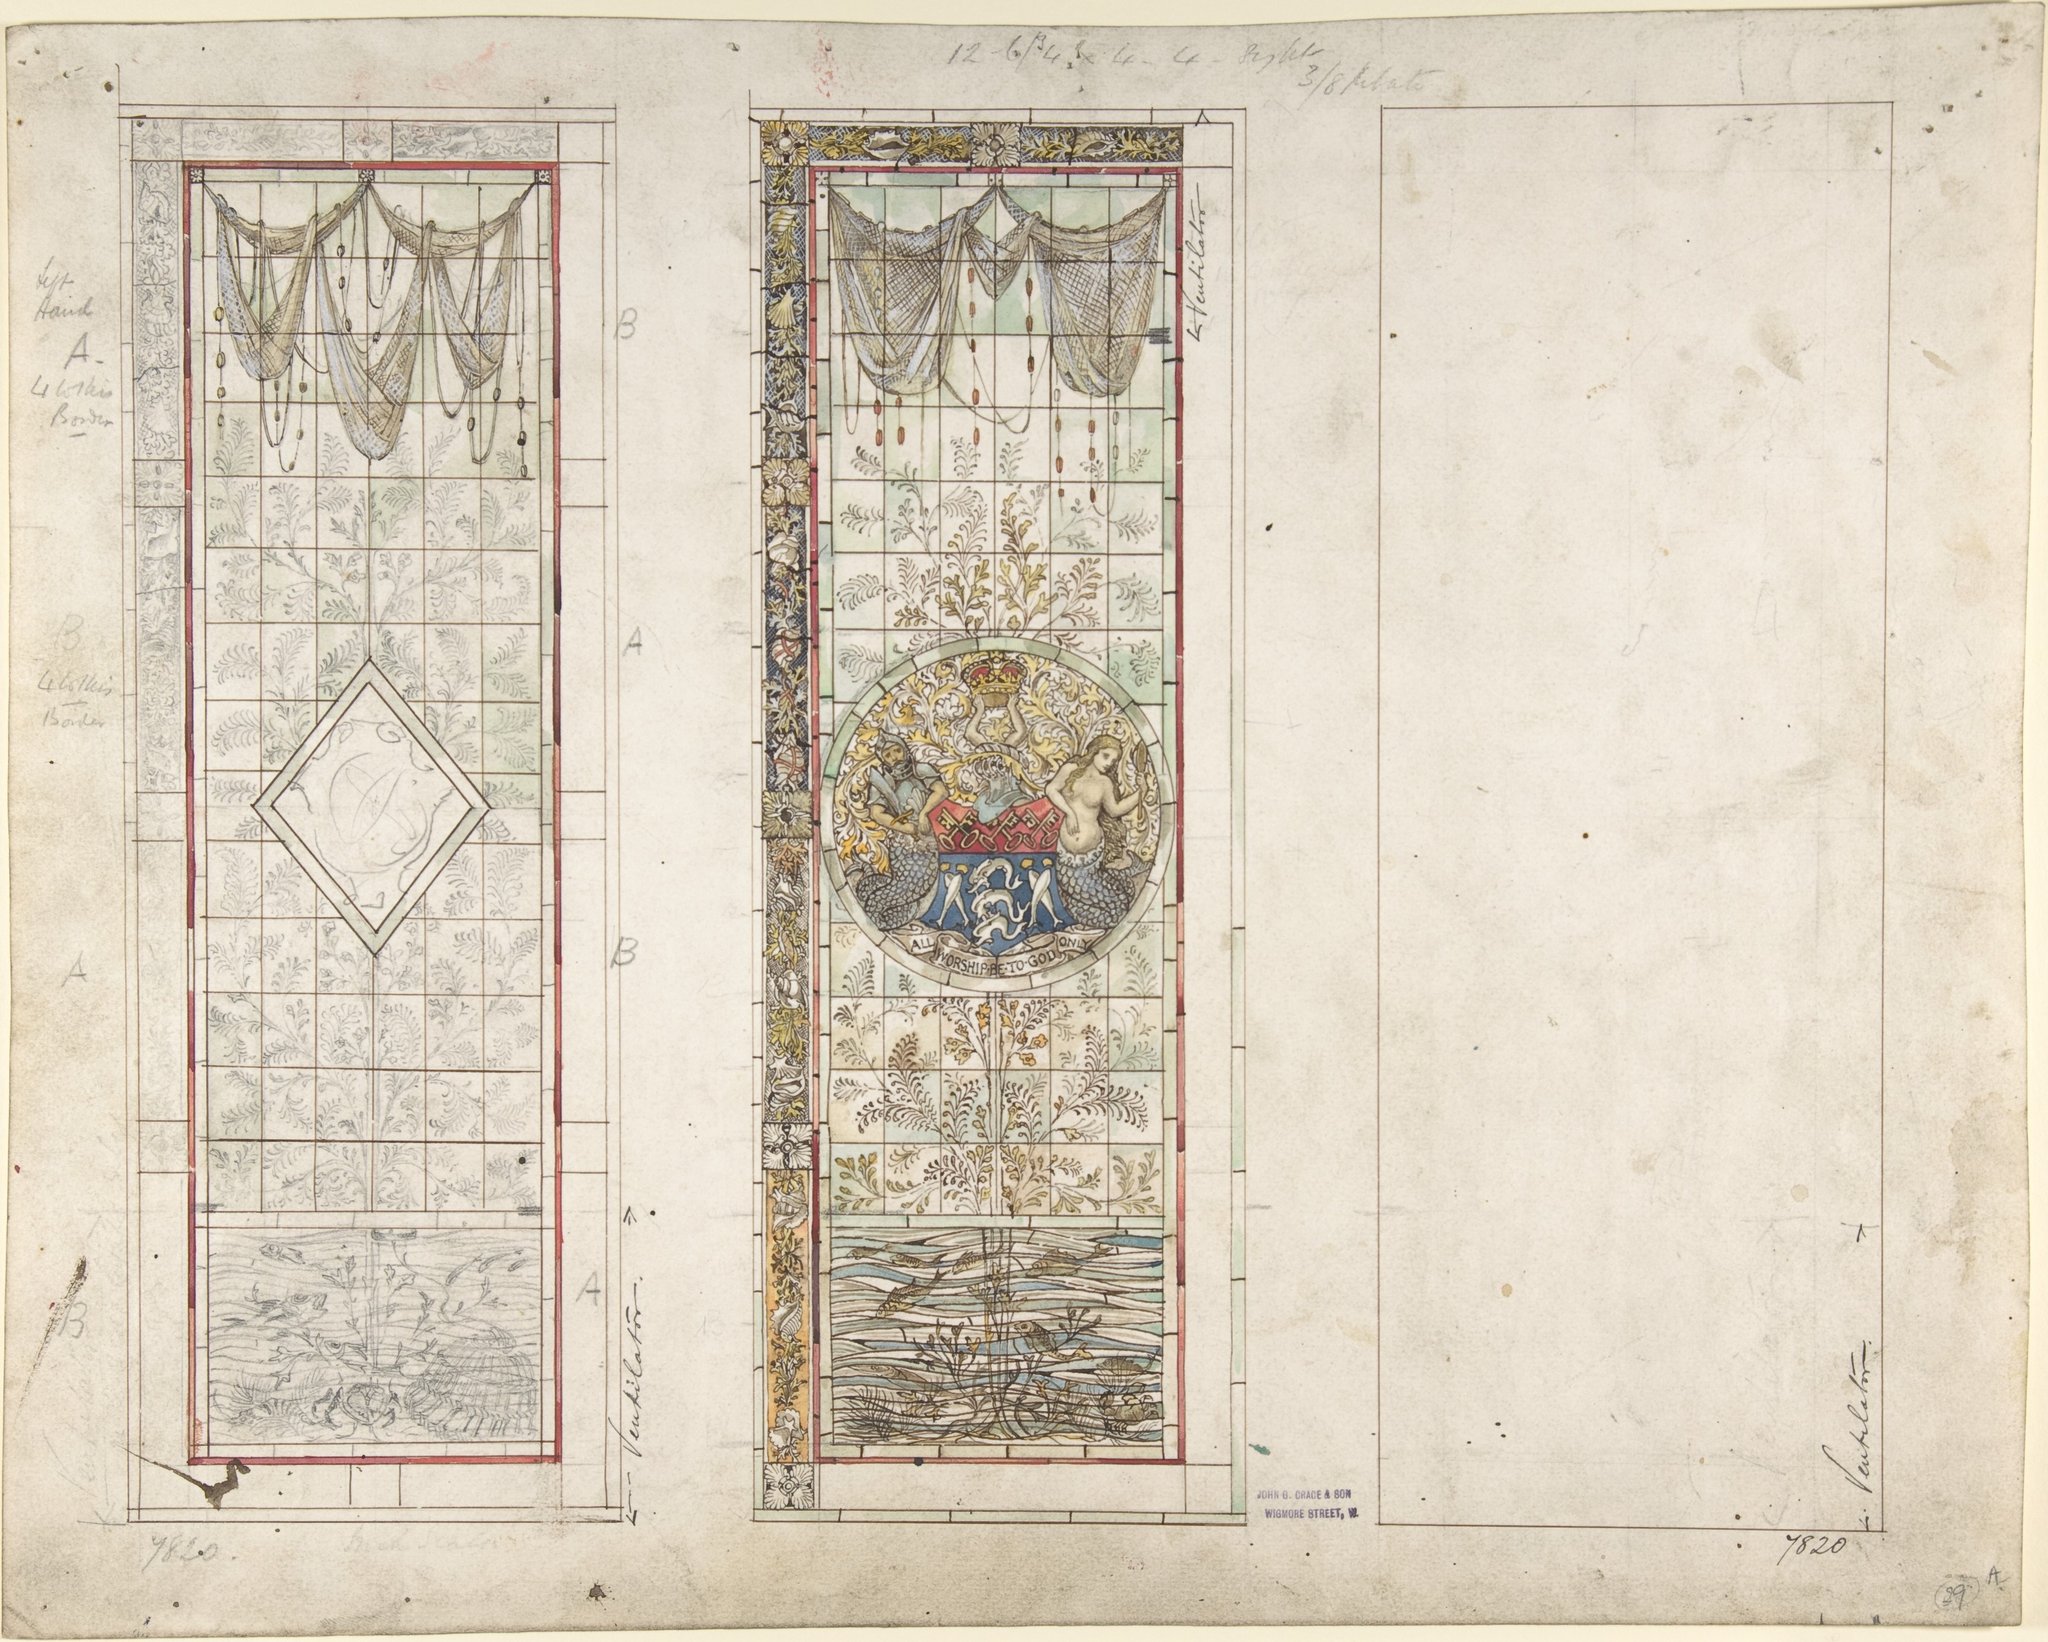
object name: drawing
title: Window with marine motifs, design for Fishmongers’ Hall, London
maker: john dibblee crace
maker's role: artist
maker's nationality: british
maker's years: 1838-1919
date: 1898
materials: graphite, ink, watercolor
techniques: pen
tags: mermaids,fish